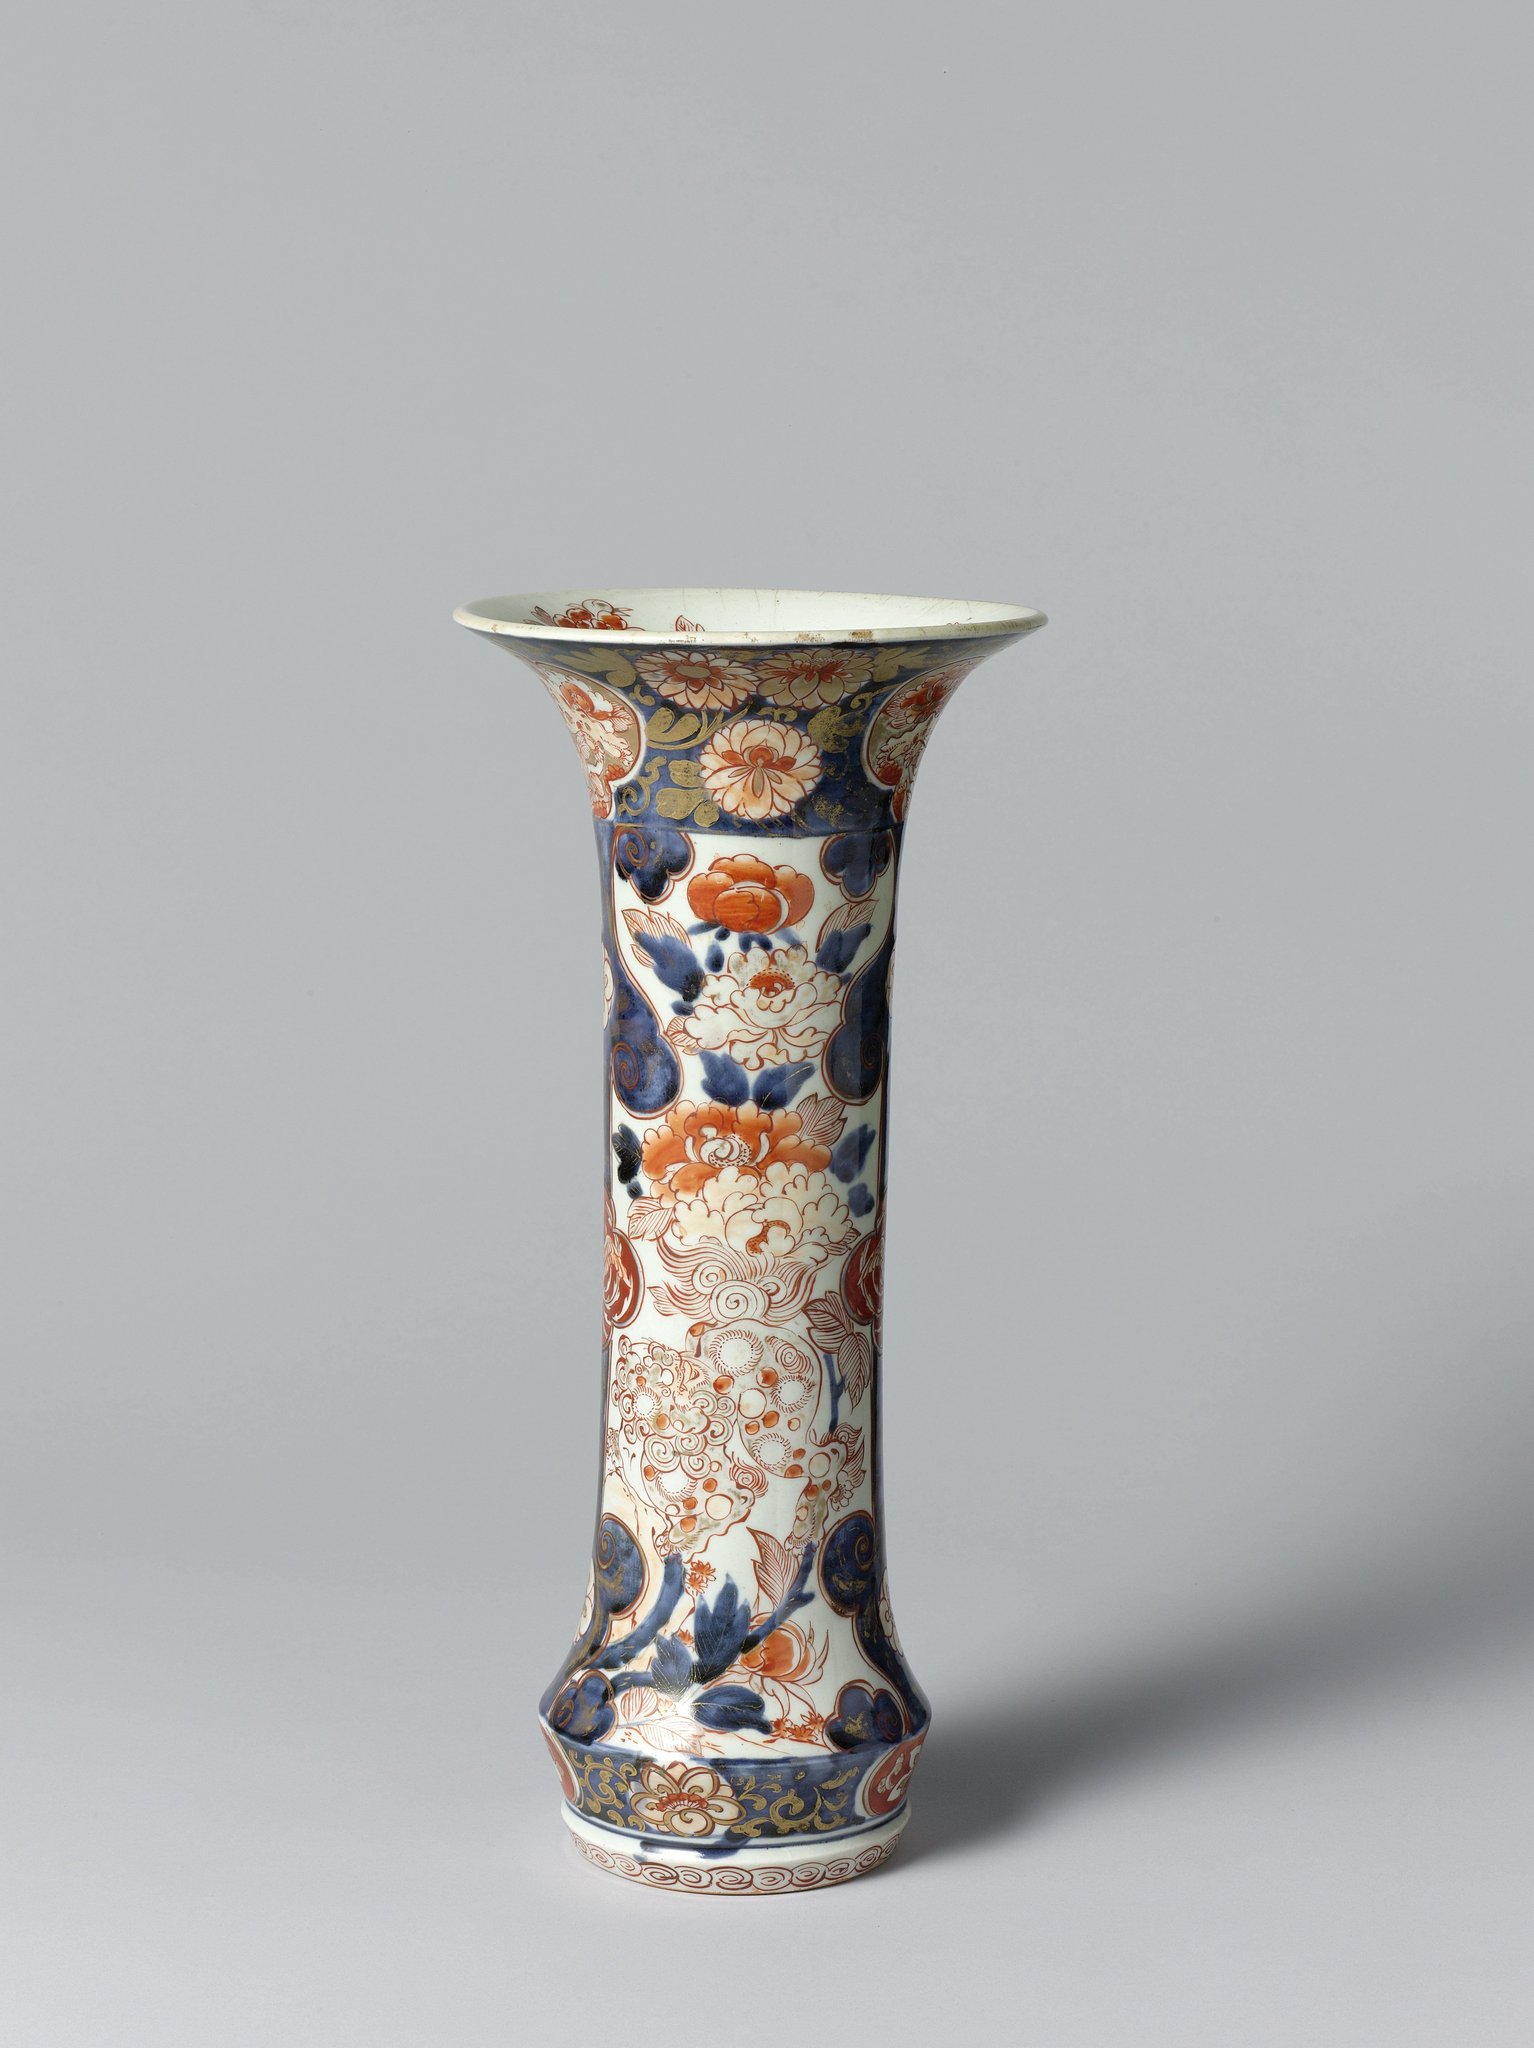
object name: bekervaas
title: Beaker vase with shishi, hoo-birds, flowering plants and floral scrolls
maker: Anonymous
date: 1775-1824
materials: cobalt, glaze, gold, paint, porcelain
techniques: firing, forming, gilding, turning, vitrification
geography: japan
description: Bekervaas van porselein met trompetvormige mond, beschilderd in onderglazuur blauw en op het glazuur rood, zwart en goud. Op de buitenwand twee grote cartouches met een shishi (leeuwhond) tussen een bloeiende pioenplant; de cartouches zijn gescheiden door banden van krulwerk met daarin een gelobd cartouche met een hoo-vogel omgeven door bloemranken. Op de buitenrand een brede band met chrysantranken onderbroken door gelobde cartouches met een shishi tussen een plant. Rond de voet een band met lotusranken. Op de voet een band met krulwerk. De binnenzijde met een pioen- en chrysanttak. Maakt onderdeel uit van een kaststel. Imari.